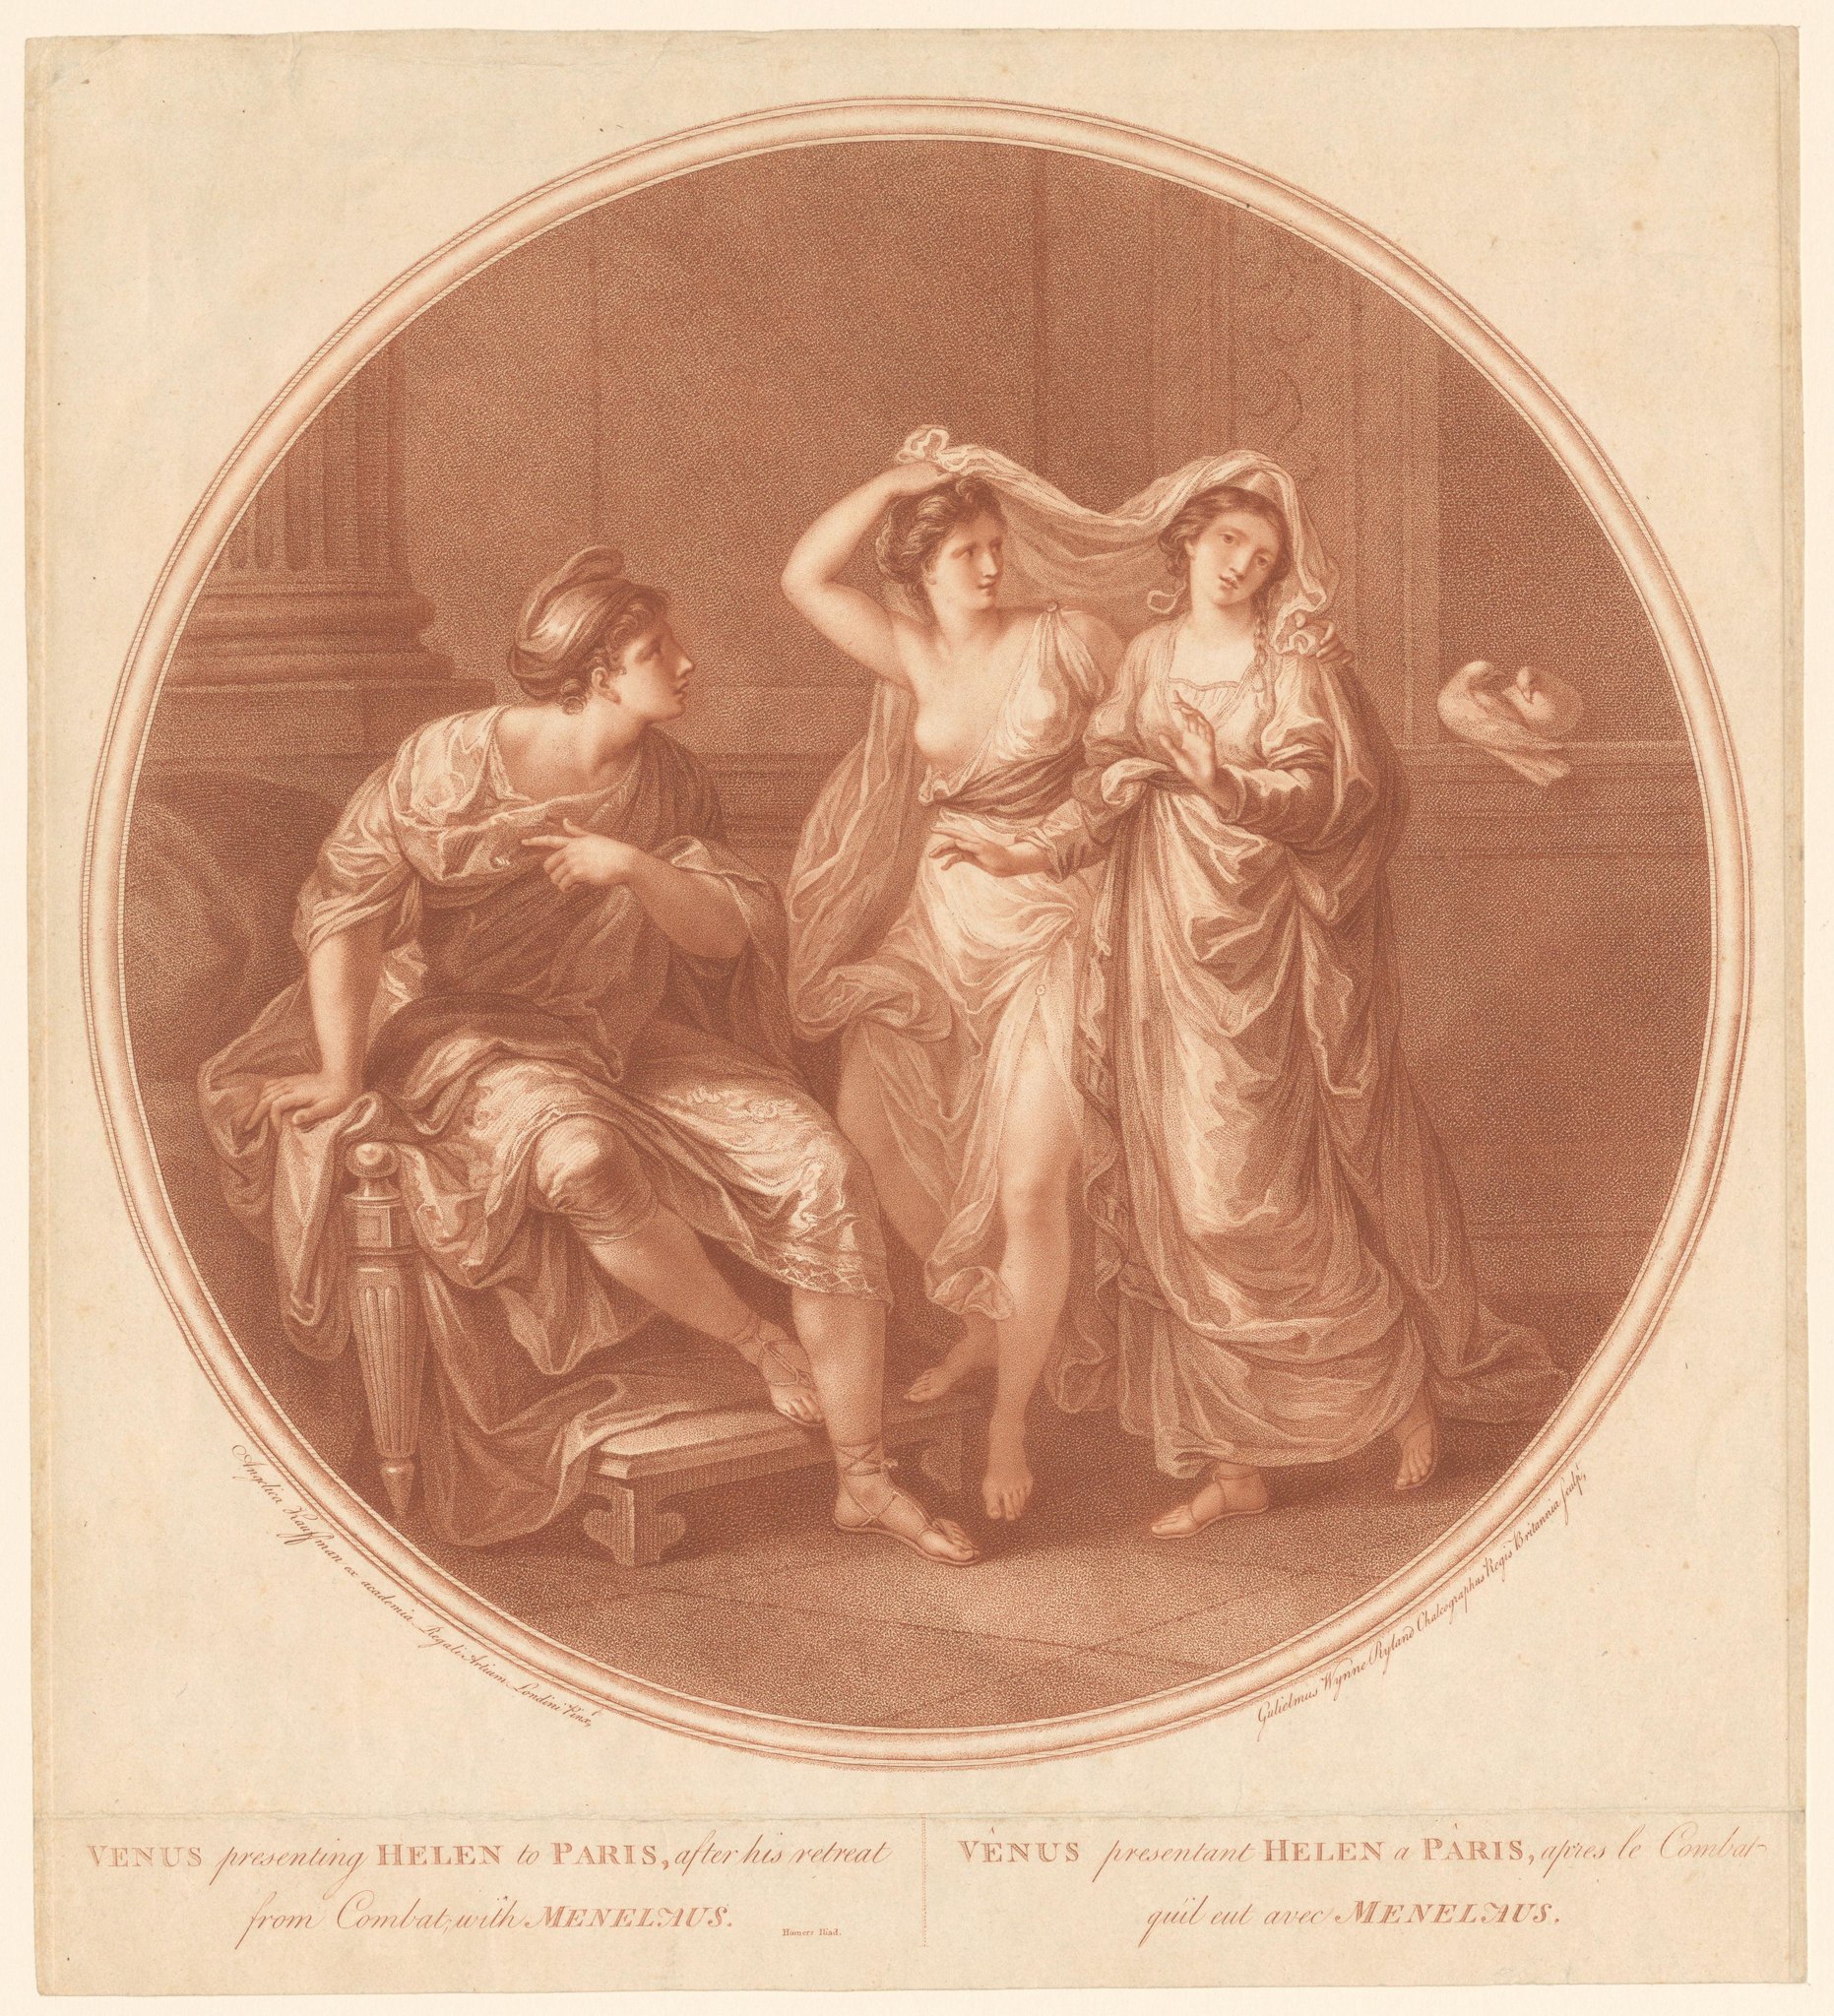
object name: print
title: Venus stelt Helena voor aan Paris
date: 1781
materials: paper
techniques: etching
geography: london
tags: paris encounters helen during a festival of venus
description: Tekst in het Engels en het Frans in de ondermarge.